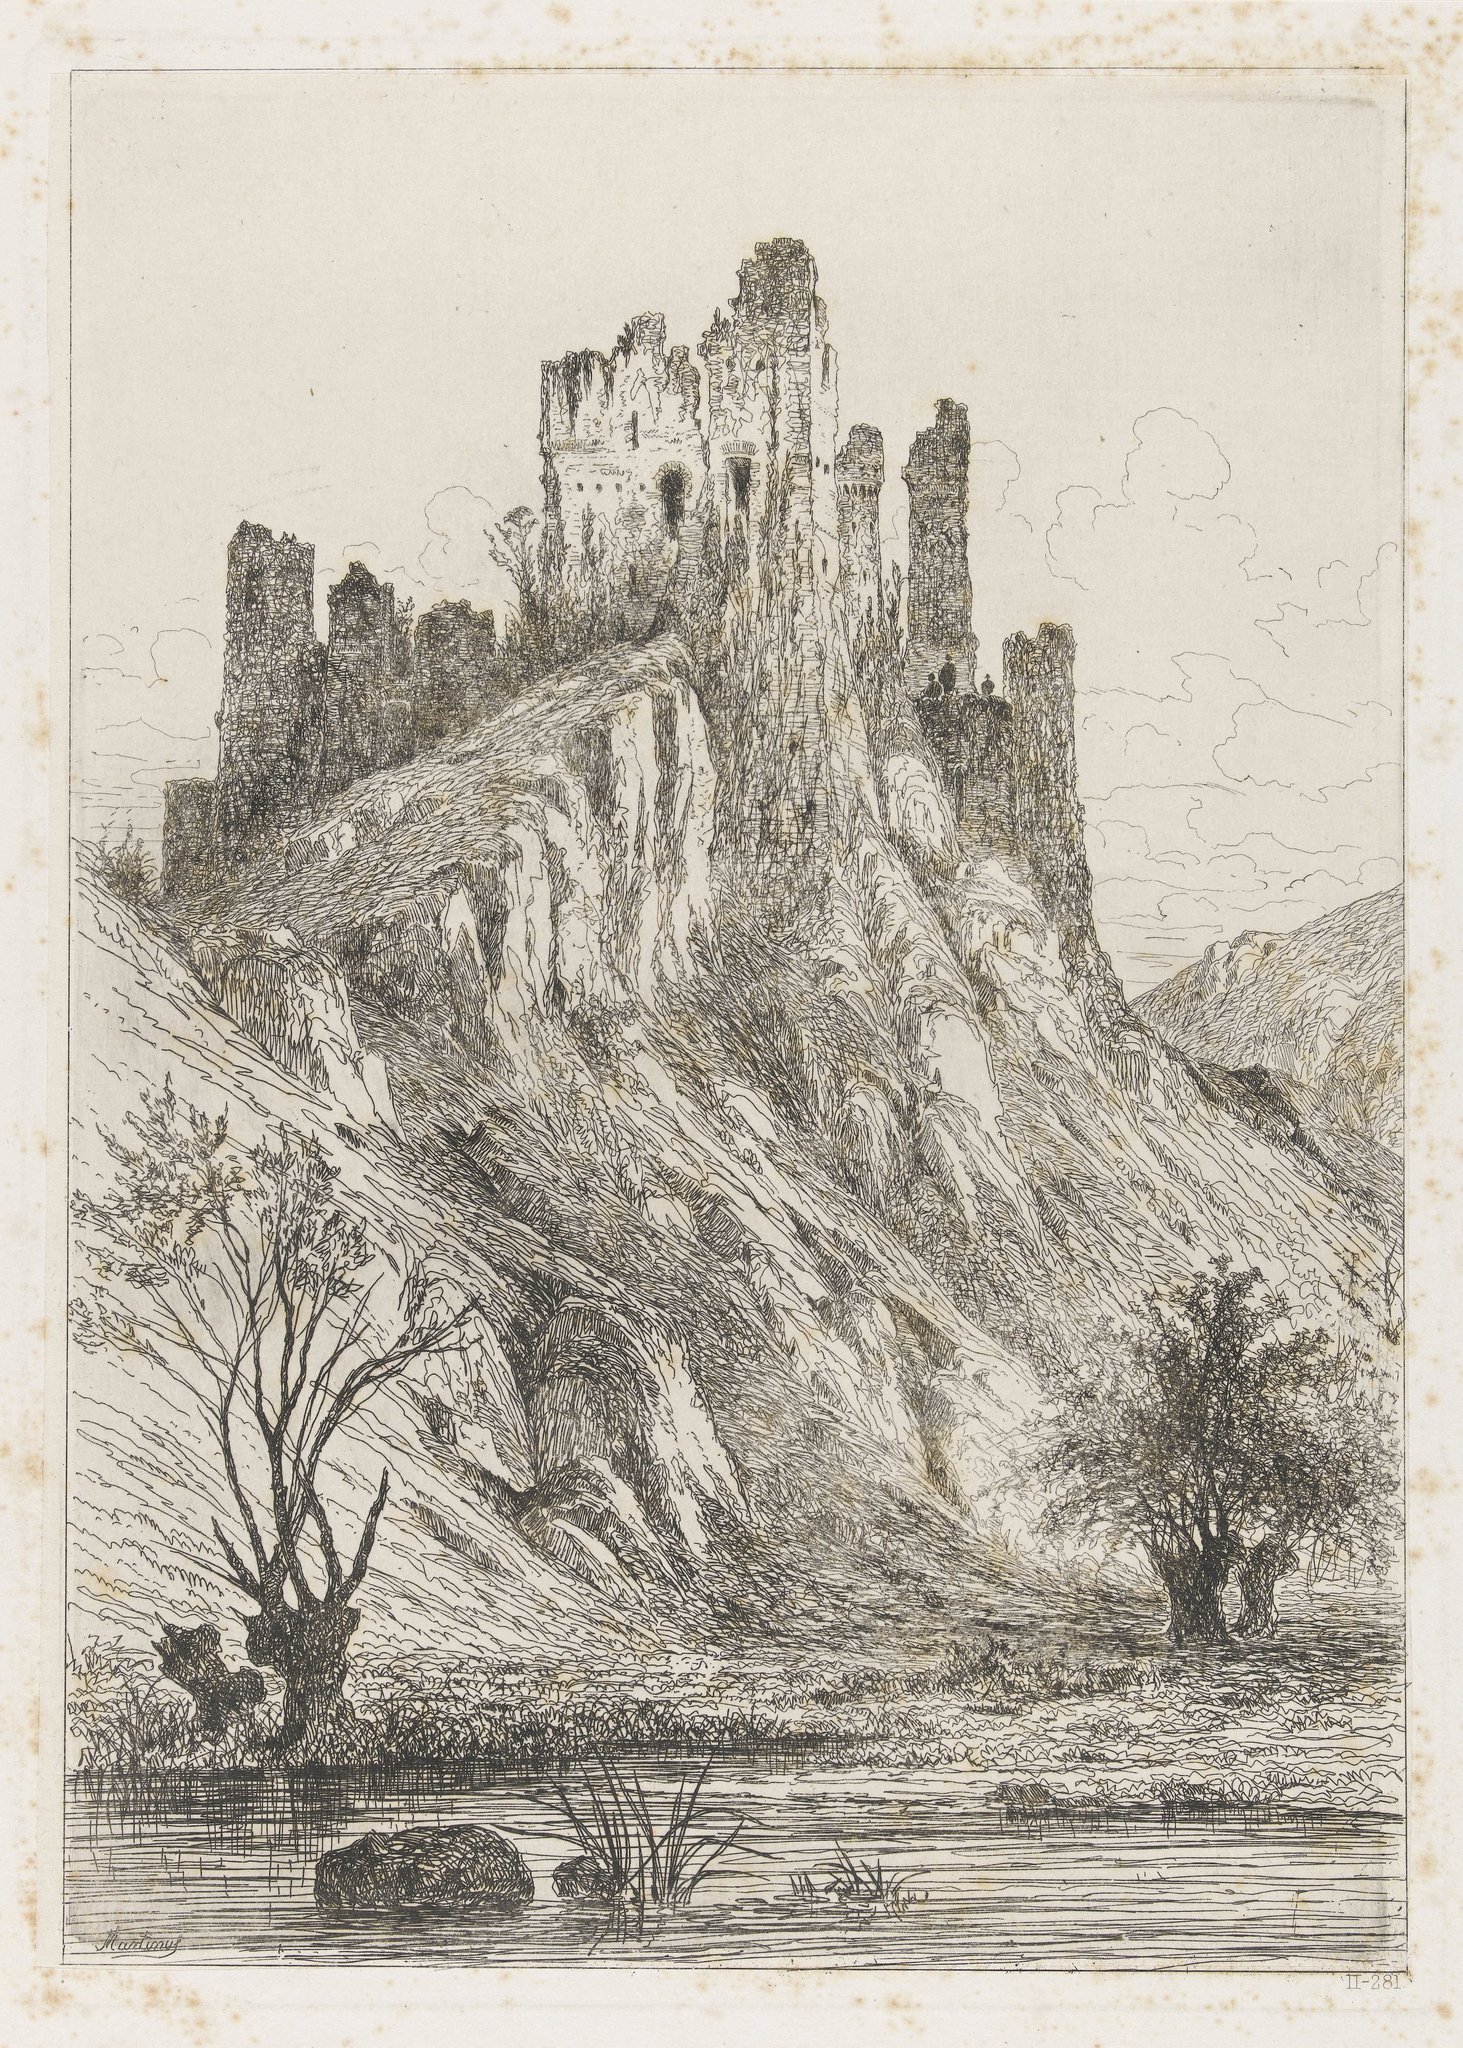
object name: print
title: Ruïne van het kasteel van Montaigle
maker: martinus antonius kuytenbrouwer jr.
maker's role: draughtsman, painter, print maker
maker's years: 1821-1897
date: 1854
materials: paper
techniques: etching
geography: brussels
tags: landscapes, (high) hill, pond, pool, ruin of a dwelling, house, castle, etc., belgium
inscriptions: collector's mark: Lugt 2228, collector's mark: Lugt 1485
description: Gezicht op de ruïne van het op een rots gelegen kasteel van Montaigle met op de voorgrond een ven. Bij de ruïne bevinden zich drie figuren.